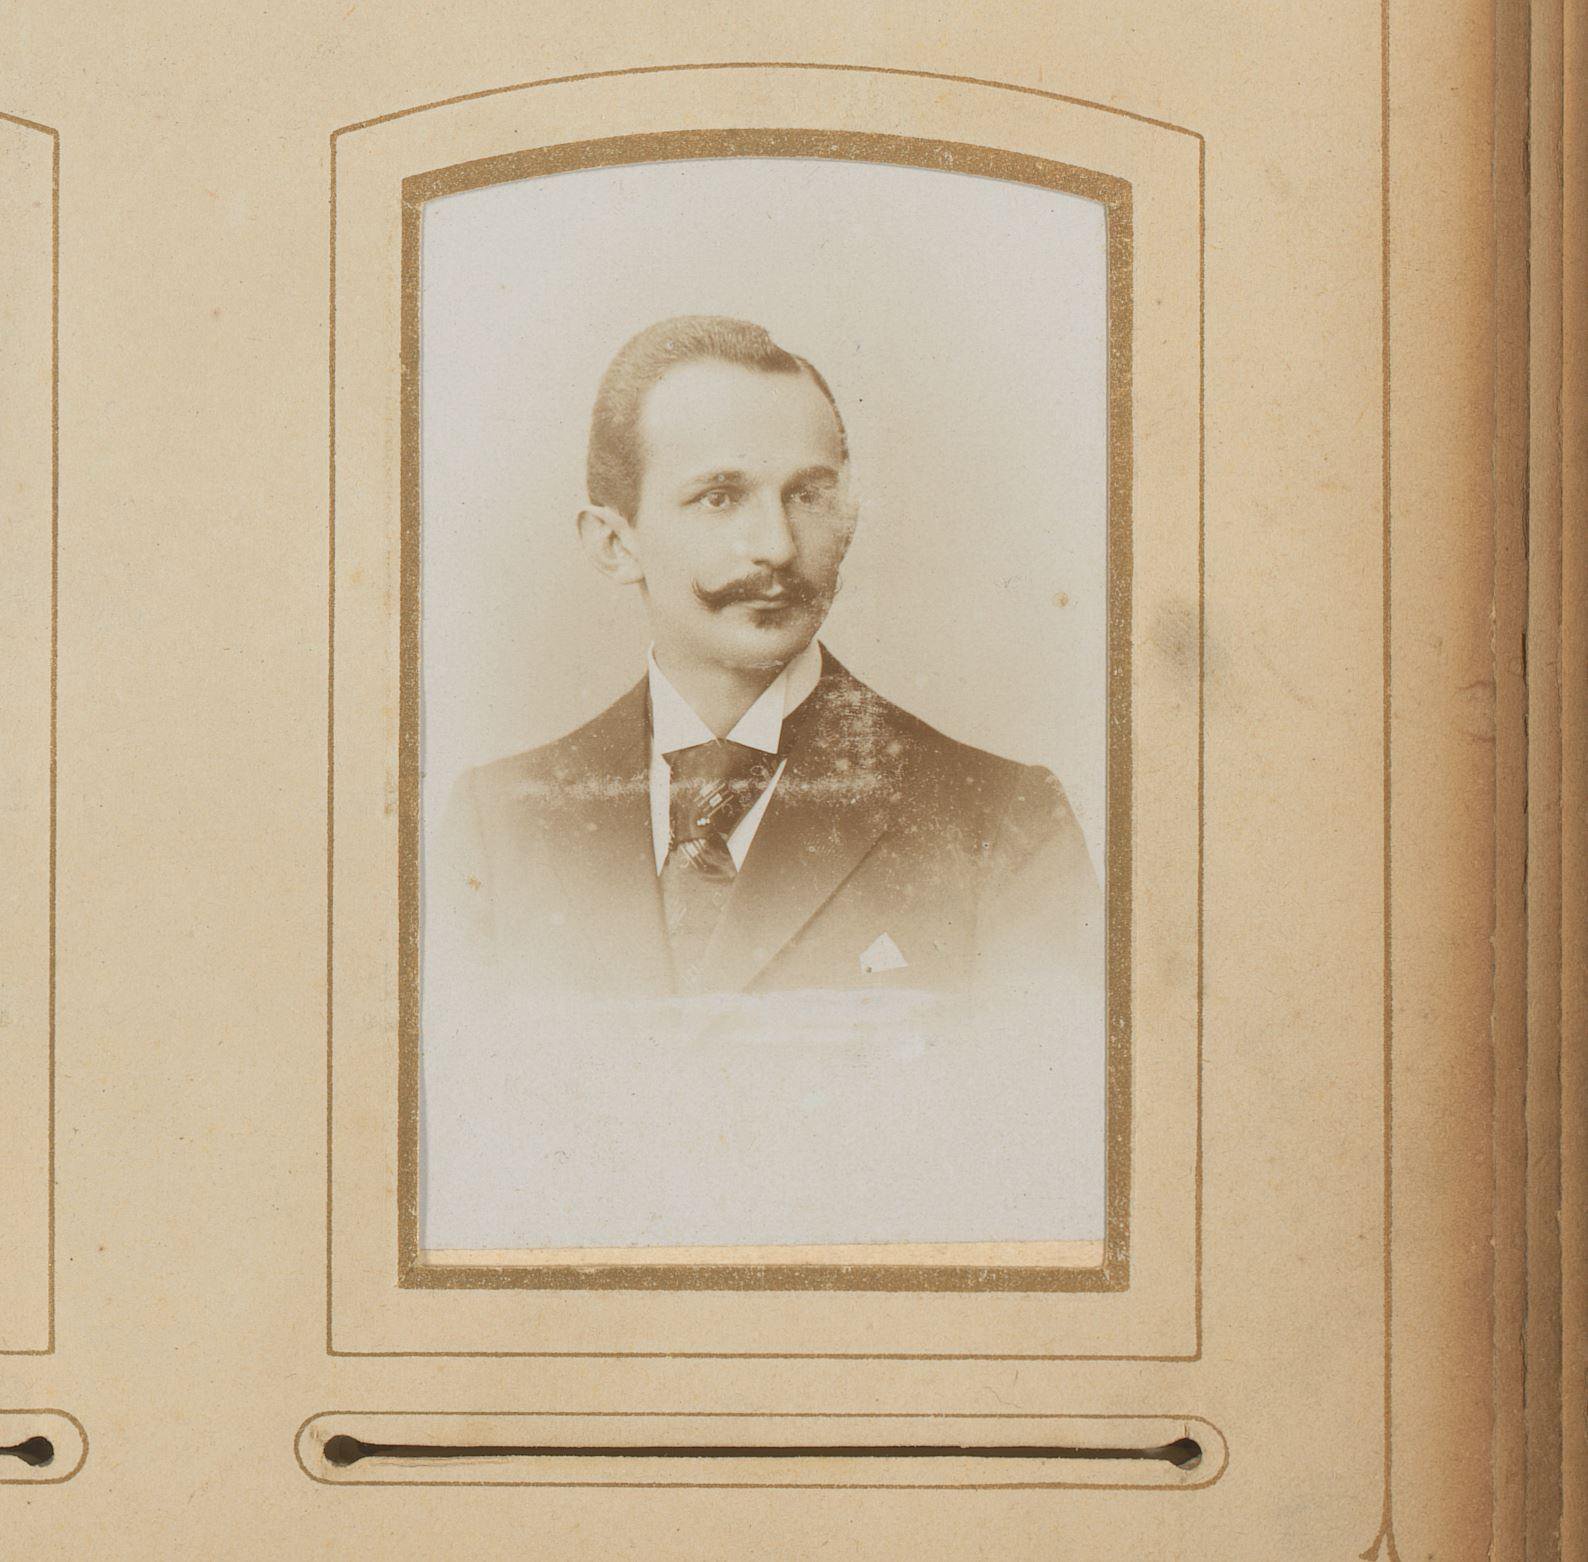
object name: photograph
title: Portret van een man met snor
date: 1880-1910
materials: cardboard, photographic support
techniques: collodion silver print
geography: germany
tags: moustache, historical persons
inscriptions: inscription: ‘Knackstedt & Näther/ Photographer/ Grosse Bleichen 30 im Garten Fernspr. 2251 AmH (...)’, inscription: ‘Knackstedt & Näther/ Photographen/ Hamburg’